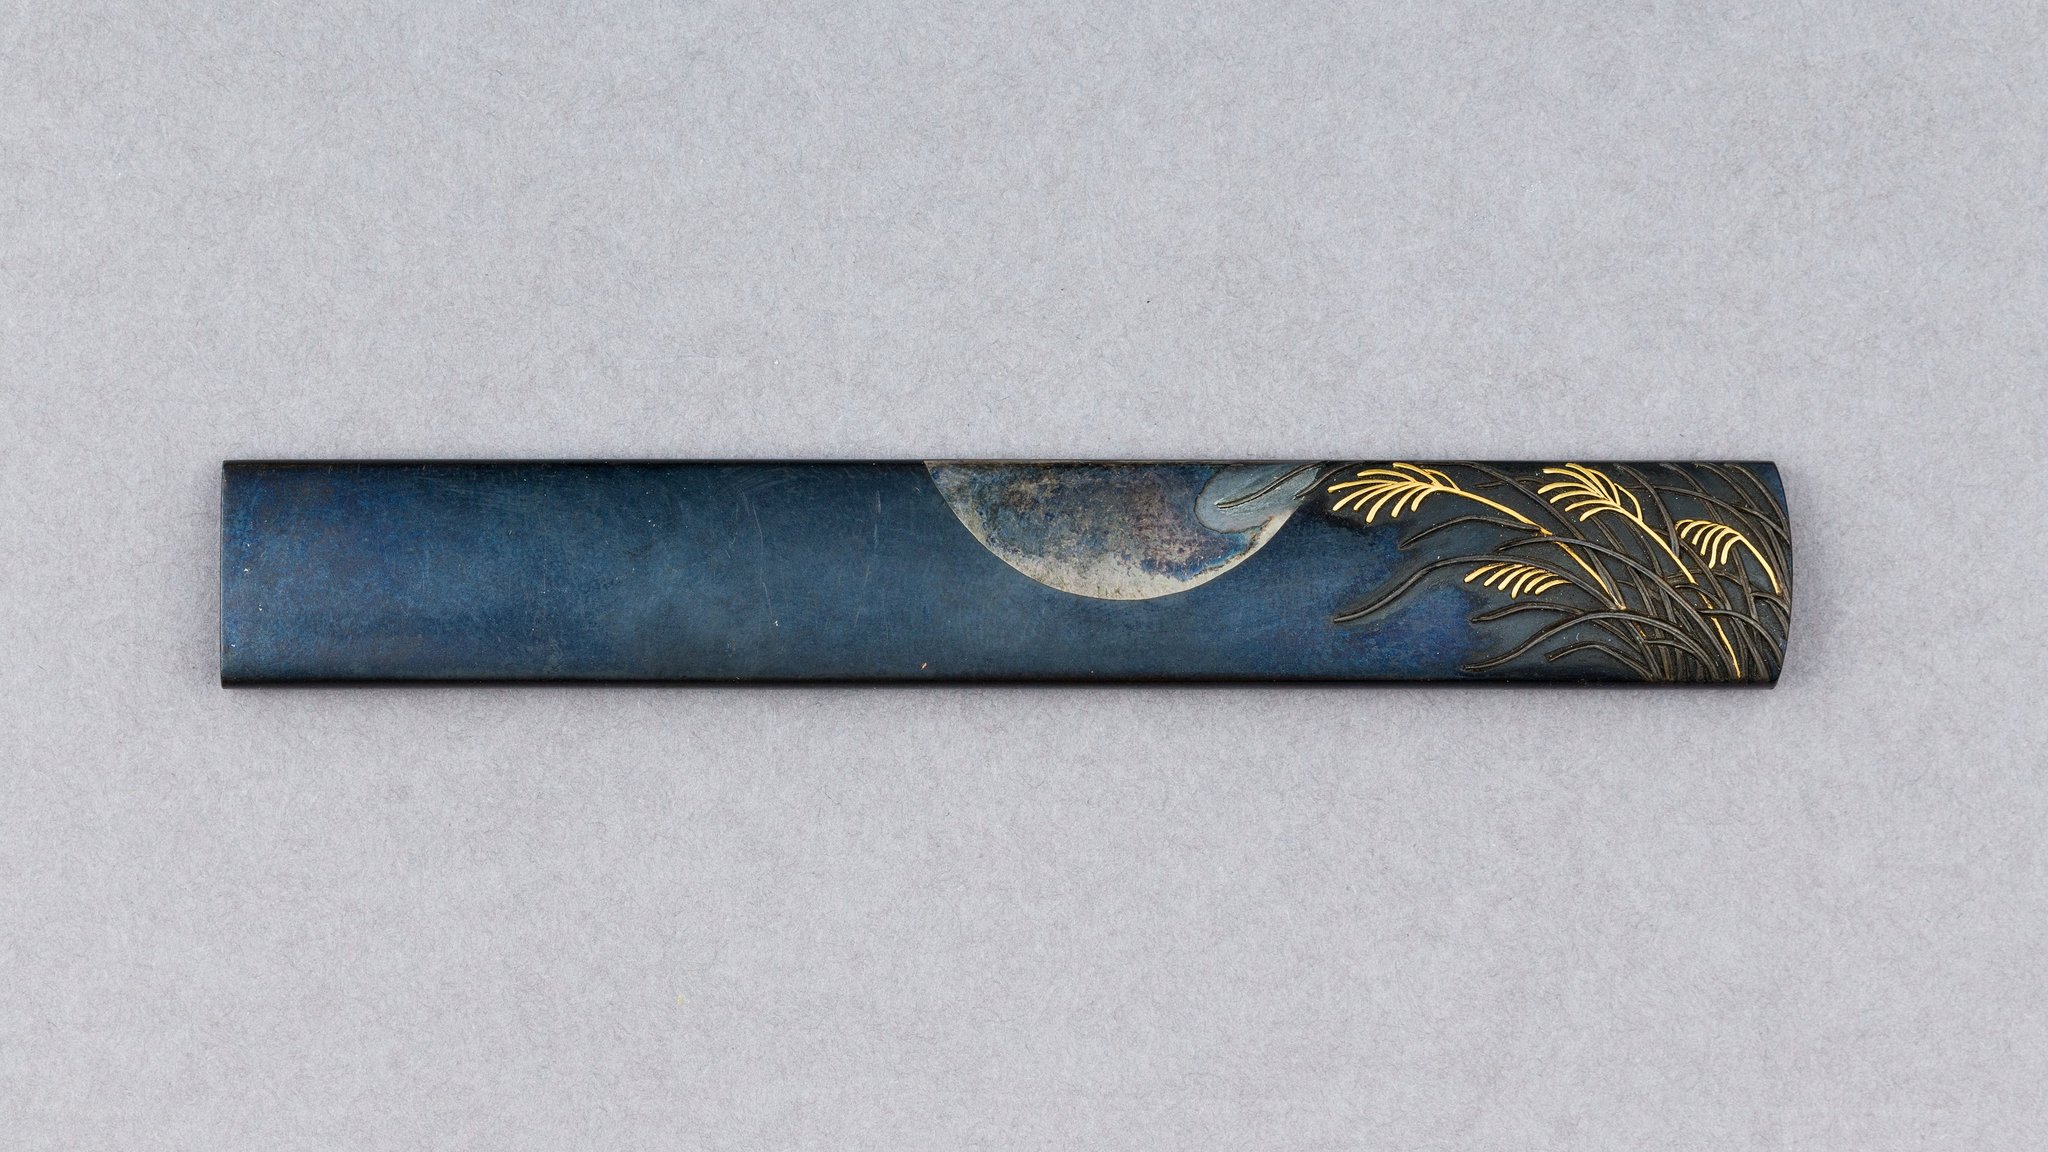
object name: knife handle kozuka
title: Knife Handle (Kozuka)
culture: japanese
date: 1615-1868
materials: gold alloy, silver alloy, gold, silver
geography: japan